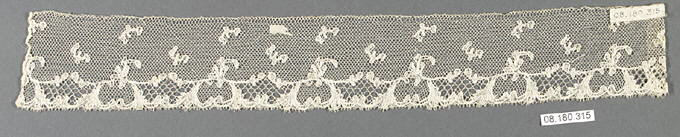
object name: fragment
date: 1767-1800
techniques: lace